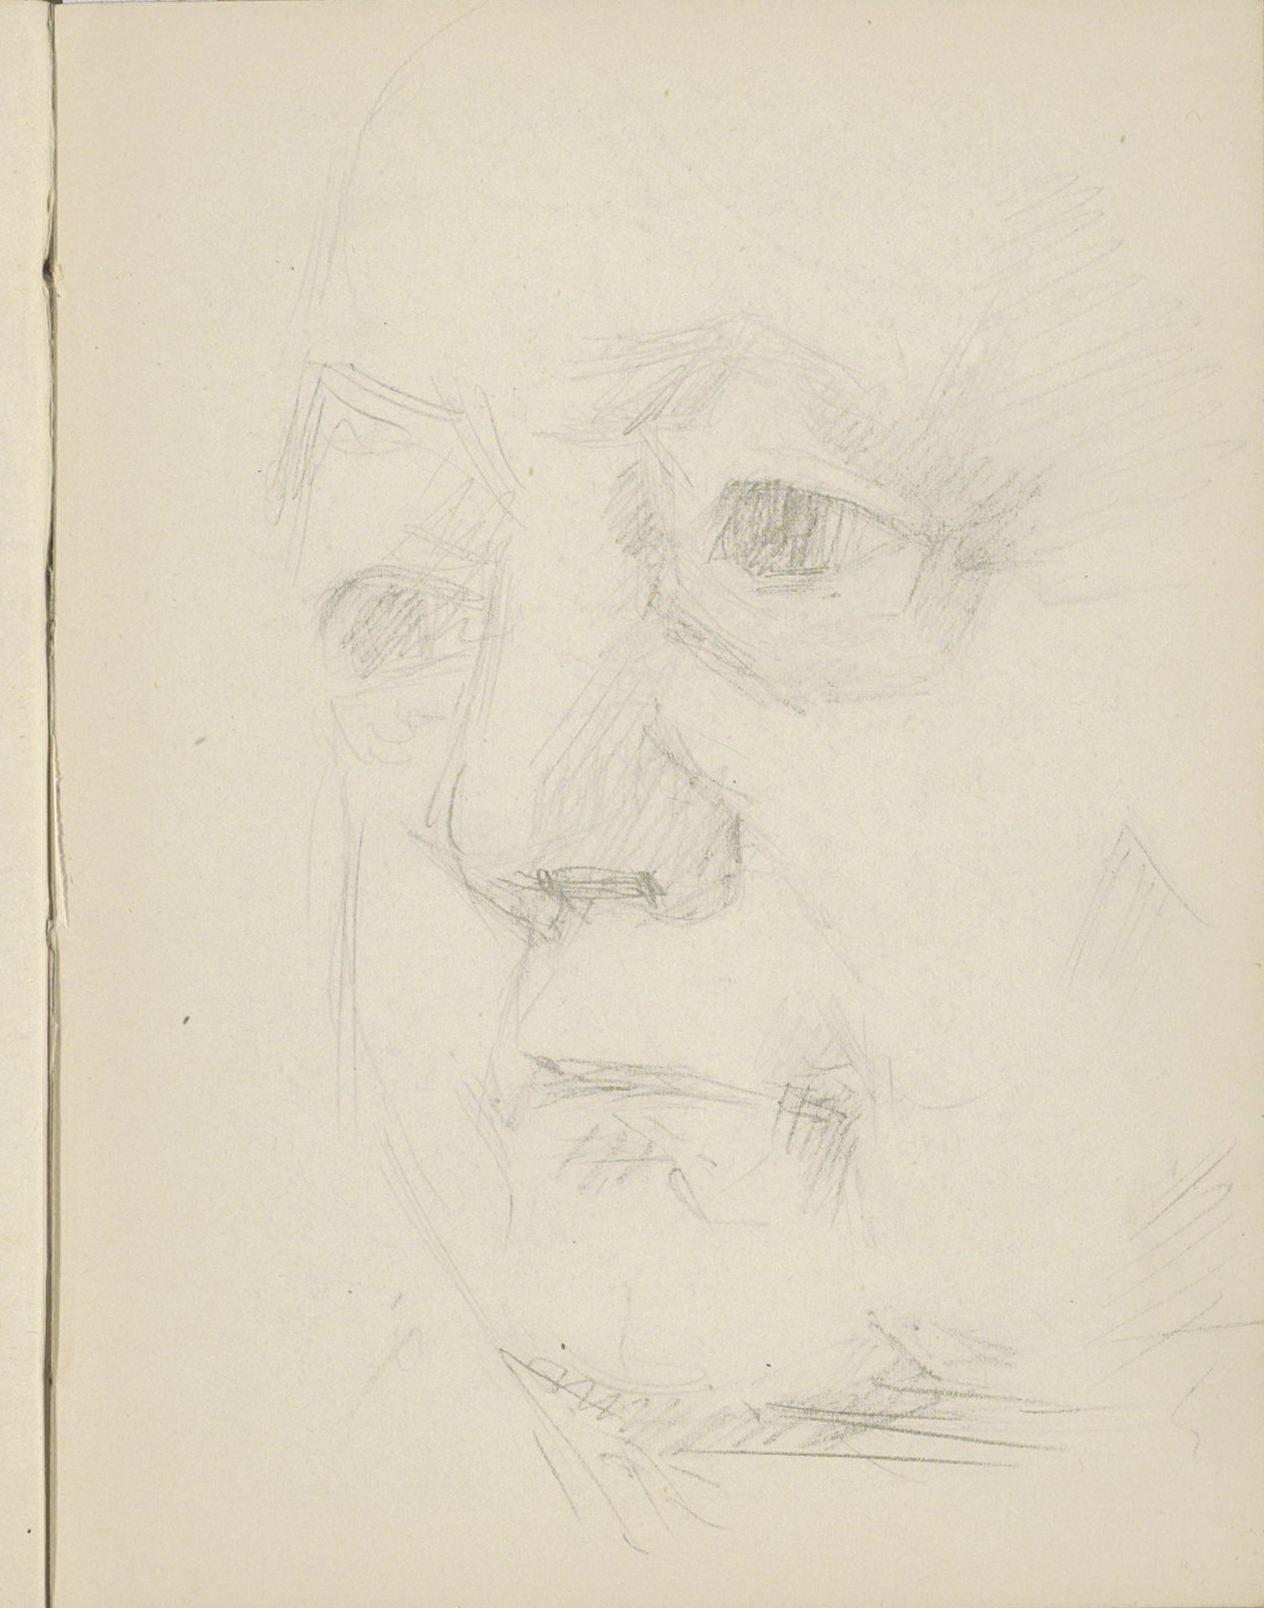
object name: sketchbook leaf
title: Gezicht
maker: reijer stolk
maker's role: draughtsman, print maker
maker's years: 1896-1945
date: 1906-1945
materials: paper, pencil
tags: face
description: Blad 63 recto uit een schetsboek met 69 bladen.